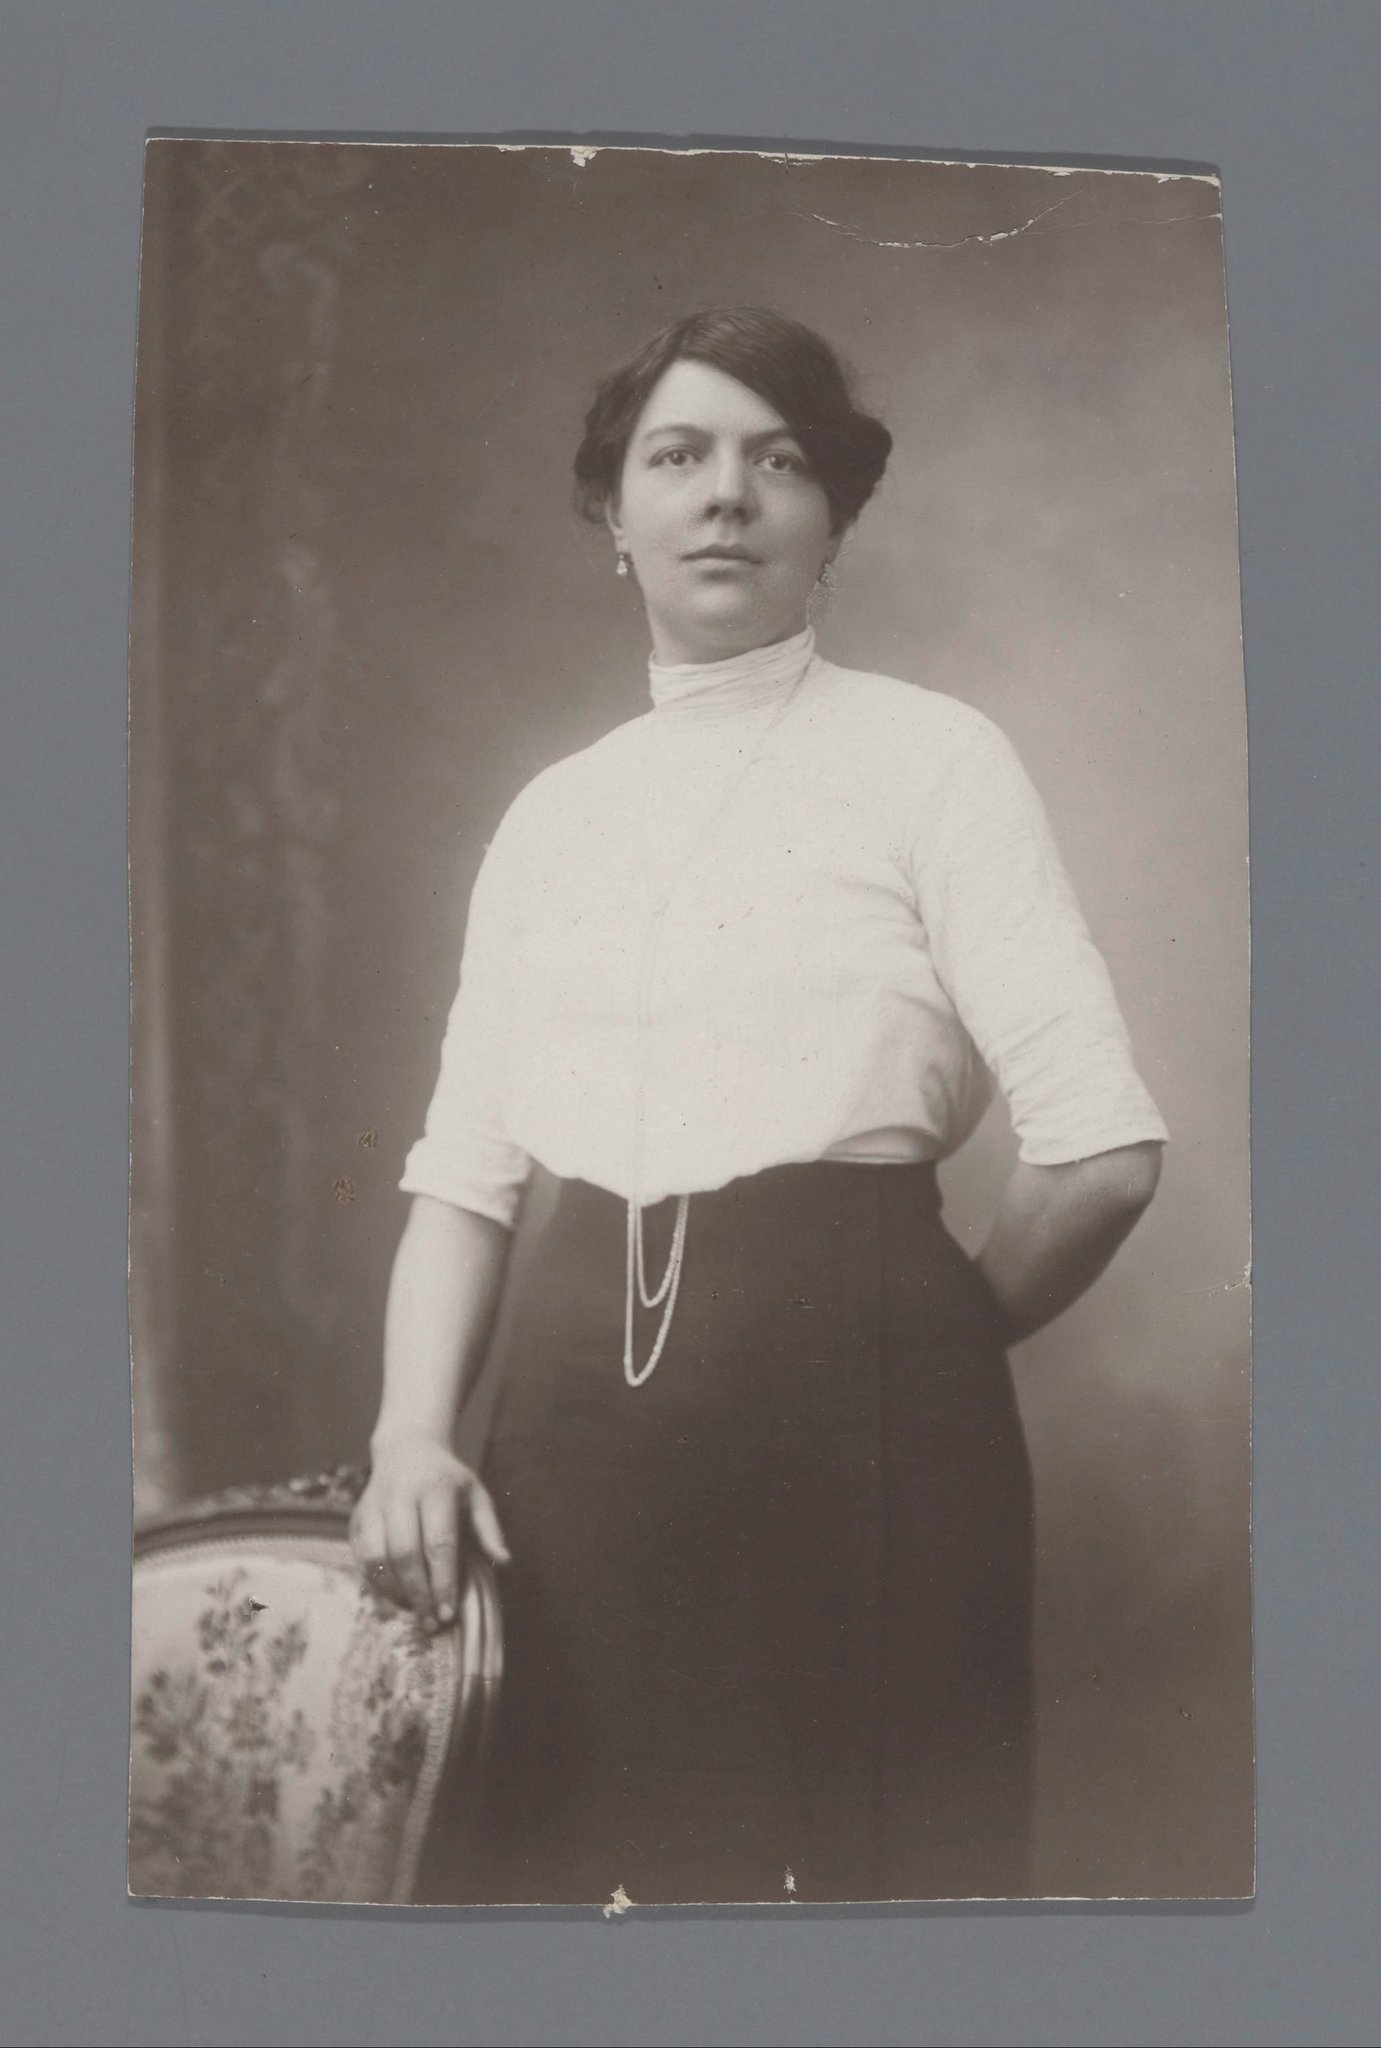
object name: photograph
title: Studioportret van een onbekende vrouw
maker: Anonymous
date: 1910-1920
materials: photographic support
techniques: gelatin silver print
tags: studio ~ photographer, adult woman